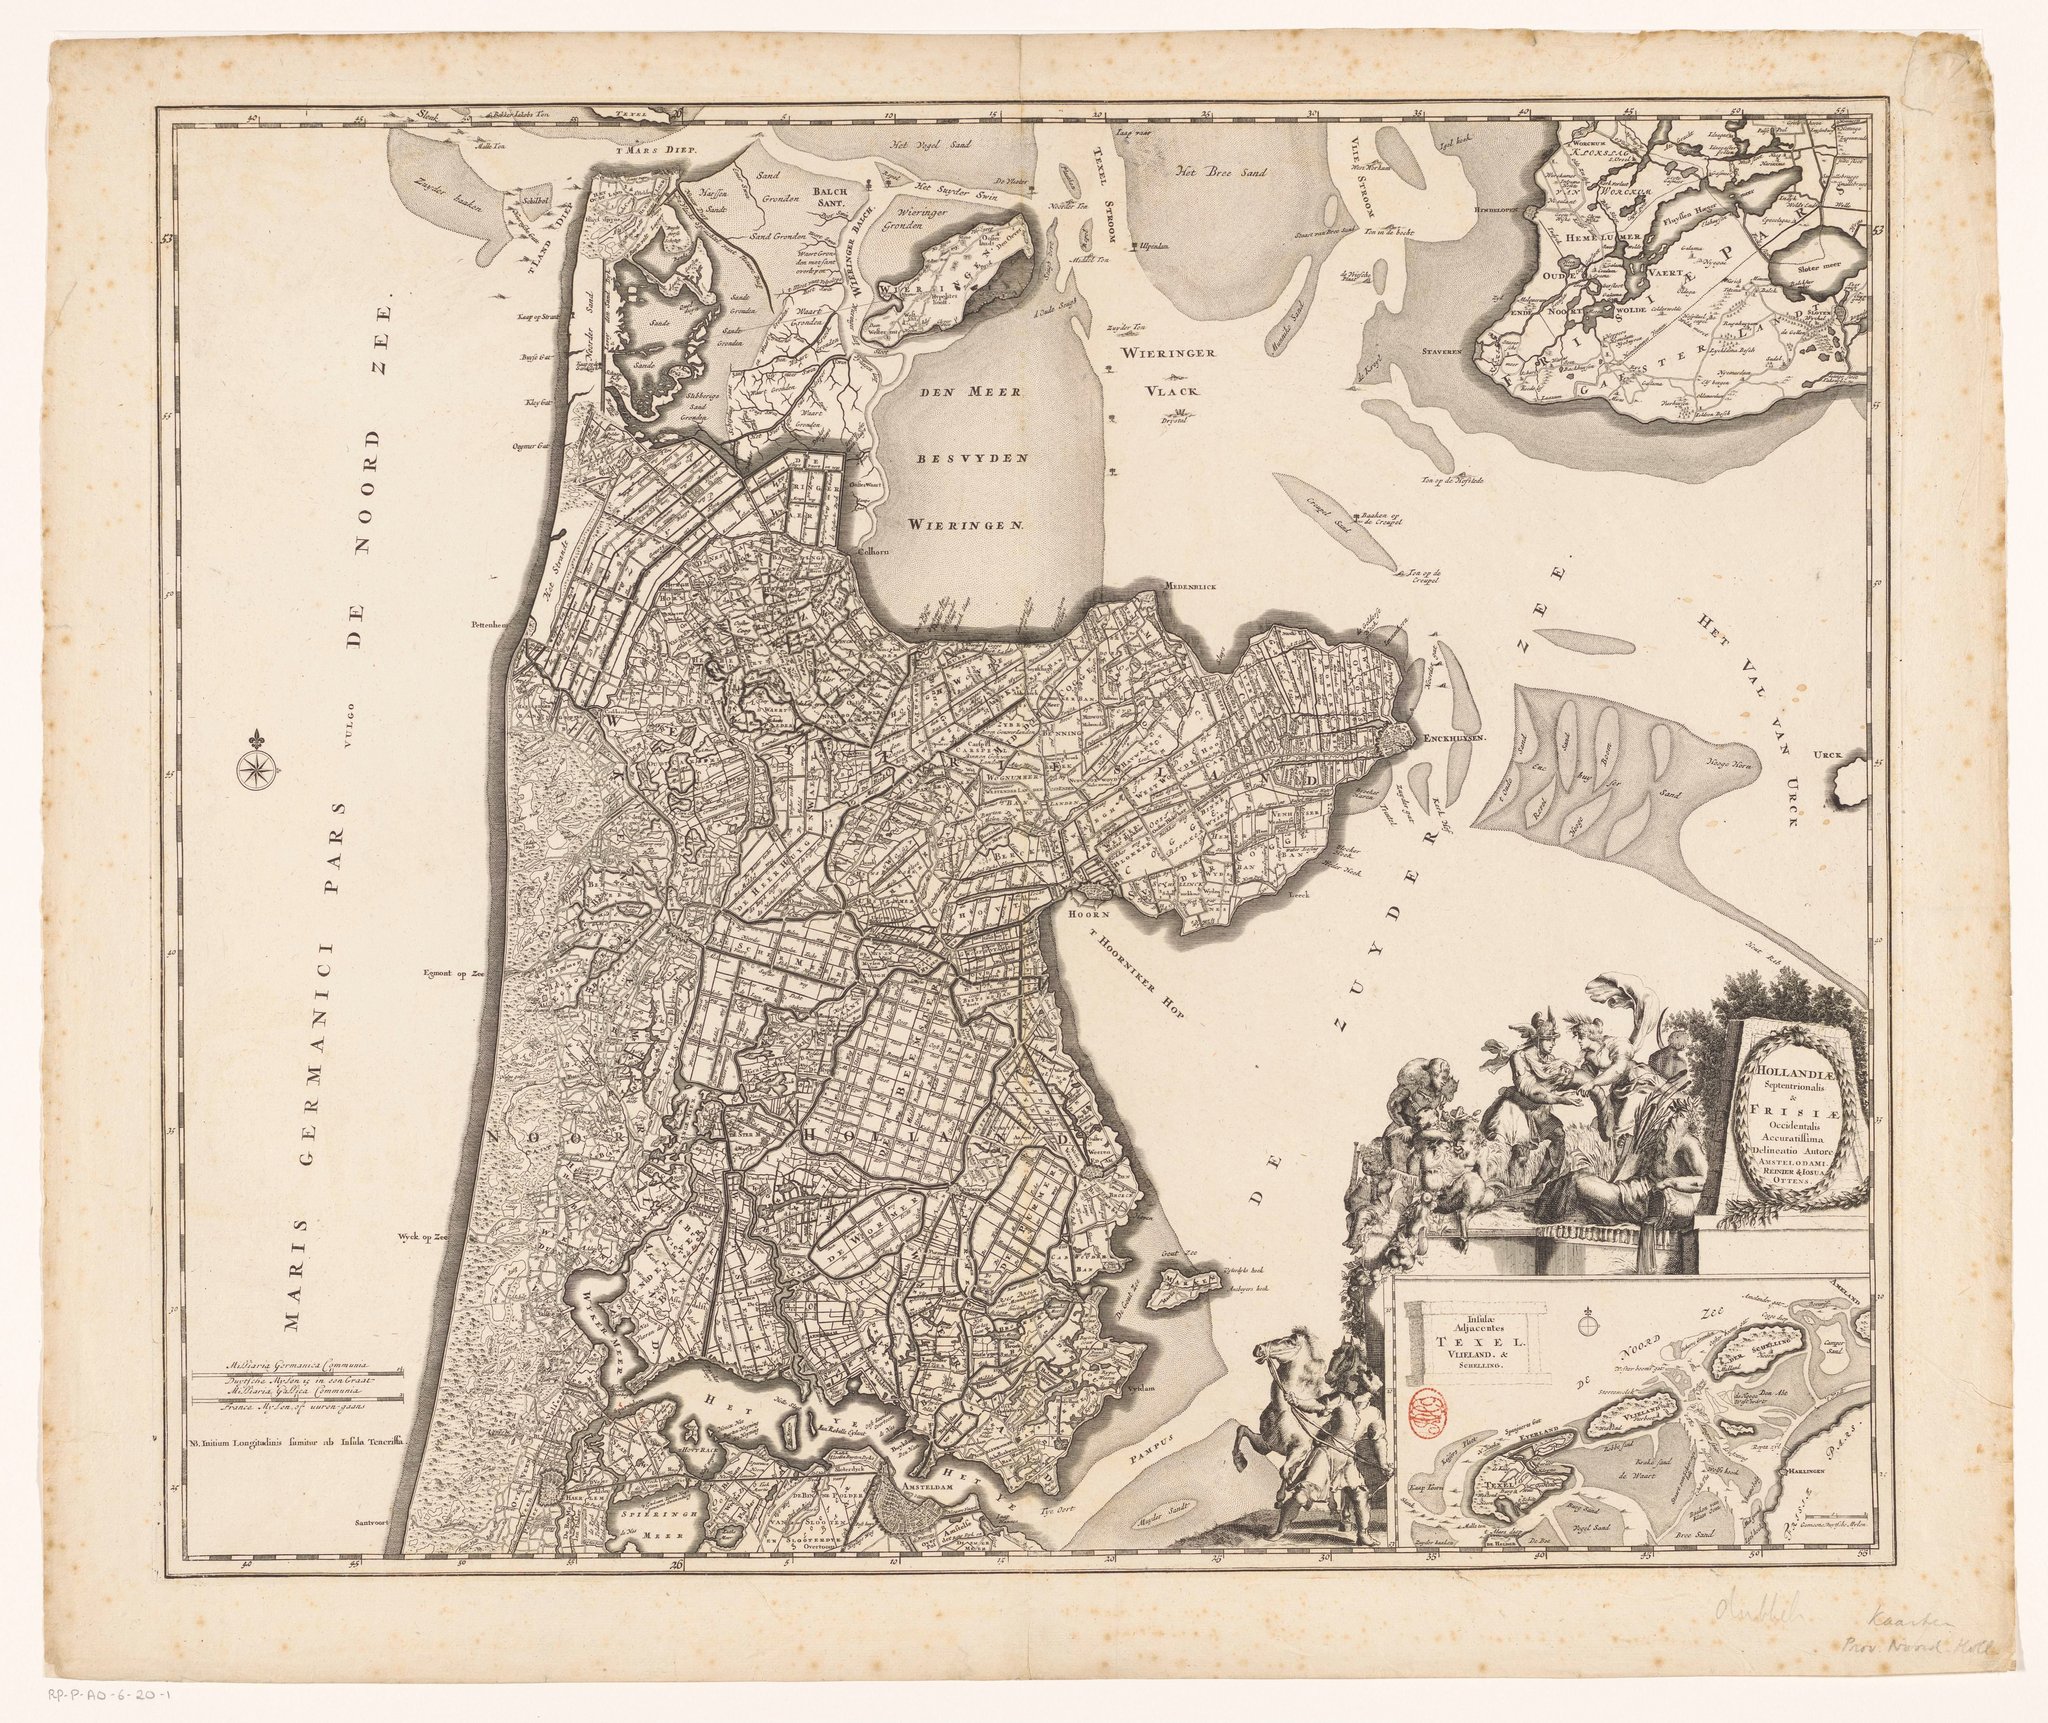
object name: print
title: Kaart van Noord-Holland en een deel van Friesland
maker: Anonymous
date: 1726-1750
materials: paper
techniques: engraving, etching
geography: amsterdam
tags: 'cornucopia', horn of plenty, maps of separate countries or regions, (story of) mercury (hermes), river-gods, satyr(s) (in general)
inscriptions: collector's mark: Lugt 195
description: Linksonder twee schaalstokken: Milliaria Germanica communia / Duytsche mylen 15 in een graat; Milliaria Gallica communia / France mylen, of uuren gaans. Rechtsonder de titelcartouche met daaromheen verschillende figuren waaronder een man met een paard, saters, putti, Mercurius die de hoorn des overvloeds aanneemt van een vrouwfiguur, en een riviergod. Daaronder een inzetkaart van het Waddengebied met een schaalstok: Gemeene Duytsche mylen. Gradenverdeling langs de randen.